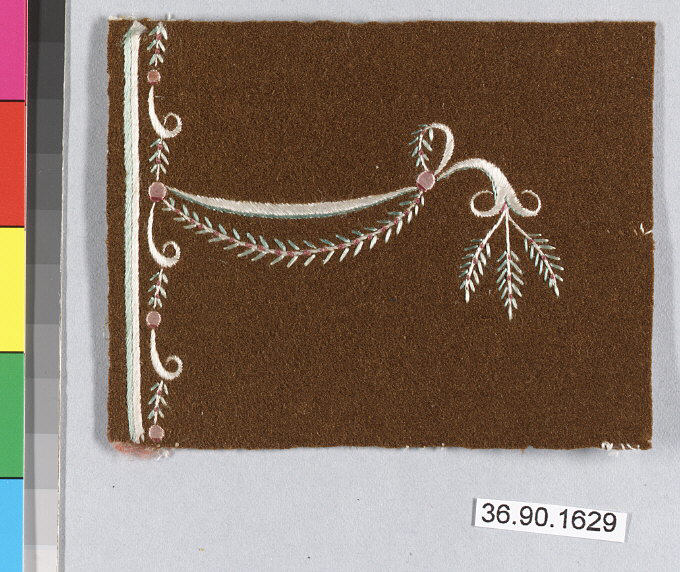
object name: sample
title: Embroidery sample for a man’s suit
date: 1785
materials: silk, wool